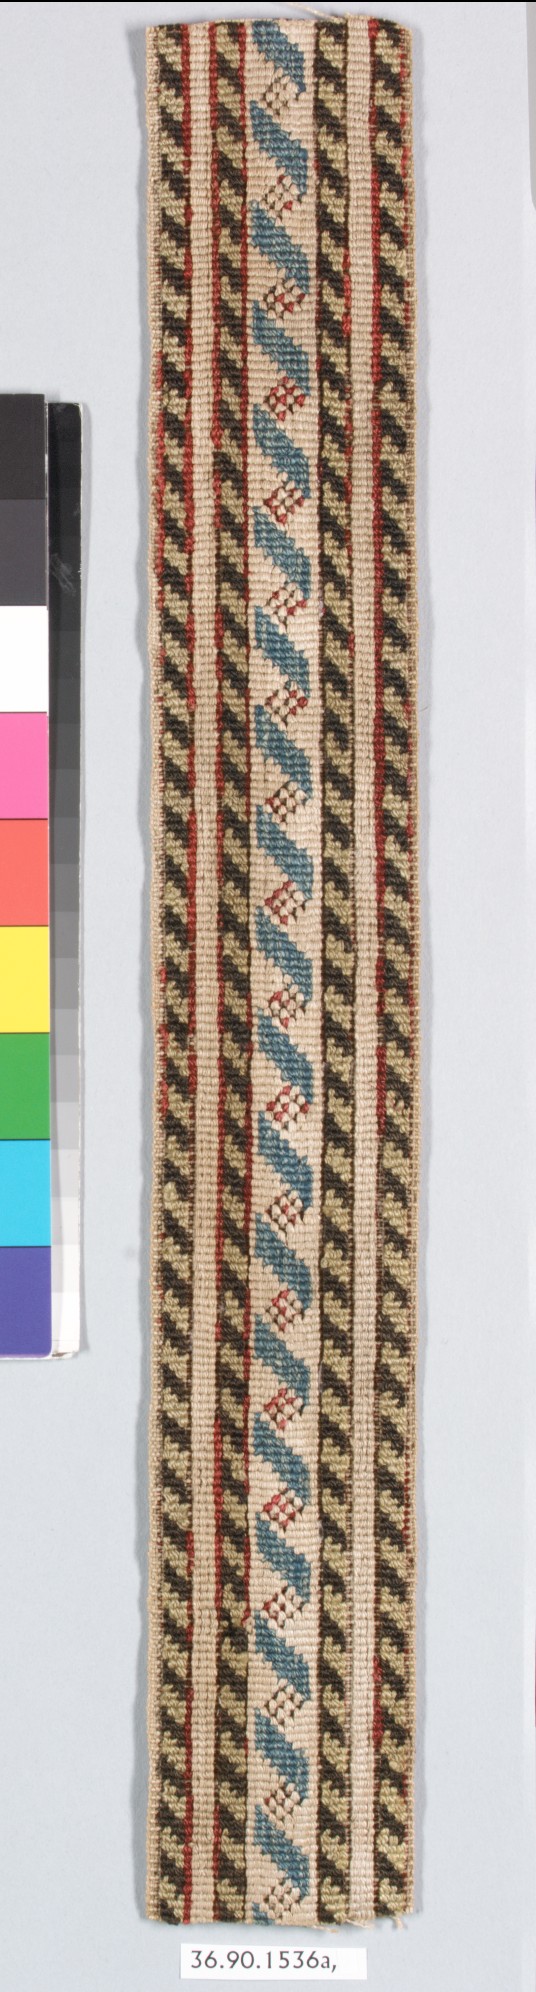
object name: galloon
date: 1701-1900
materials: silk